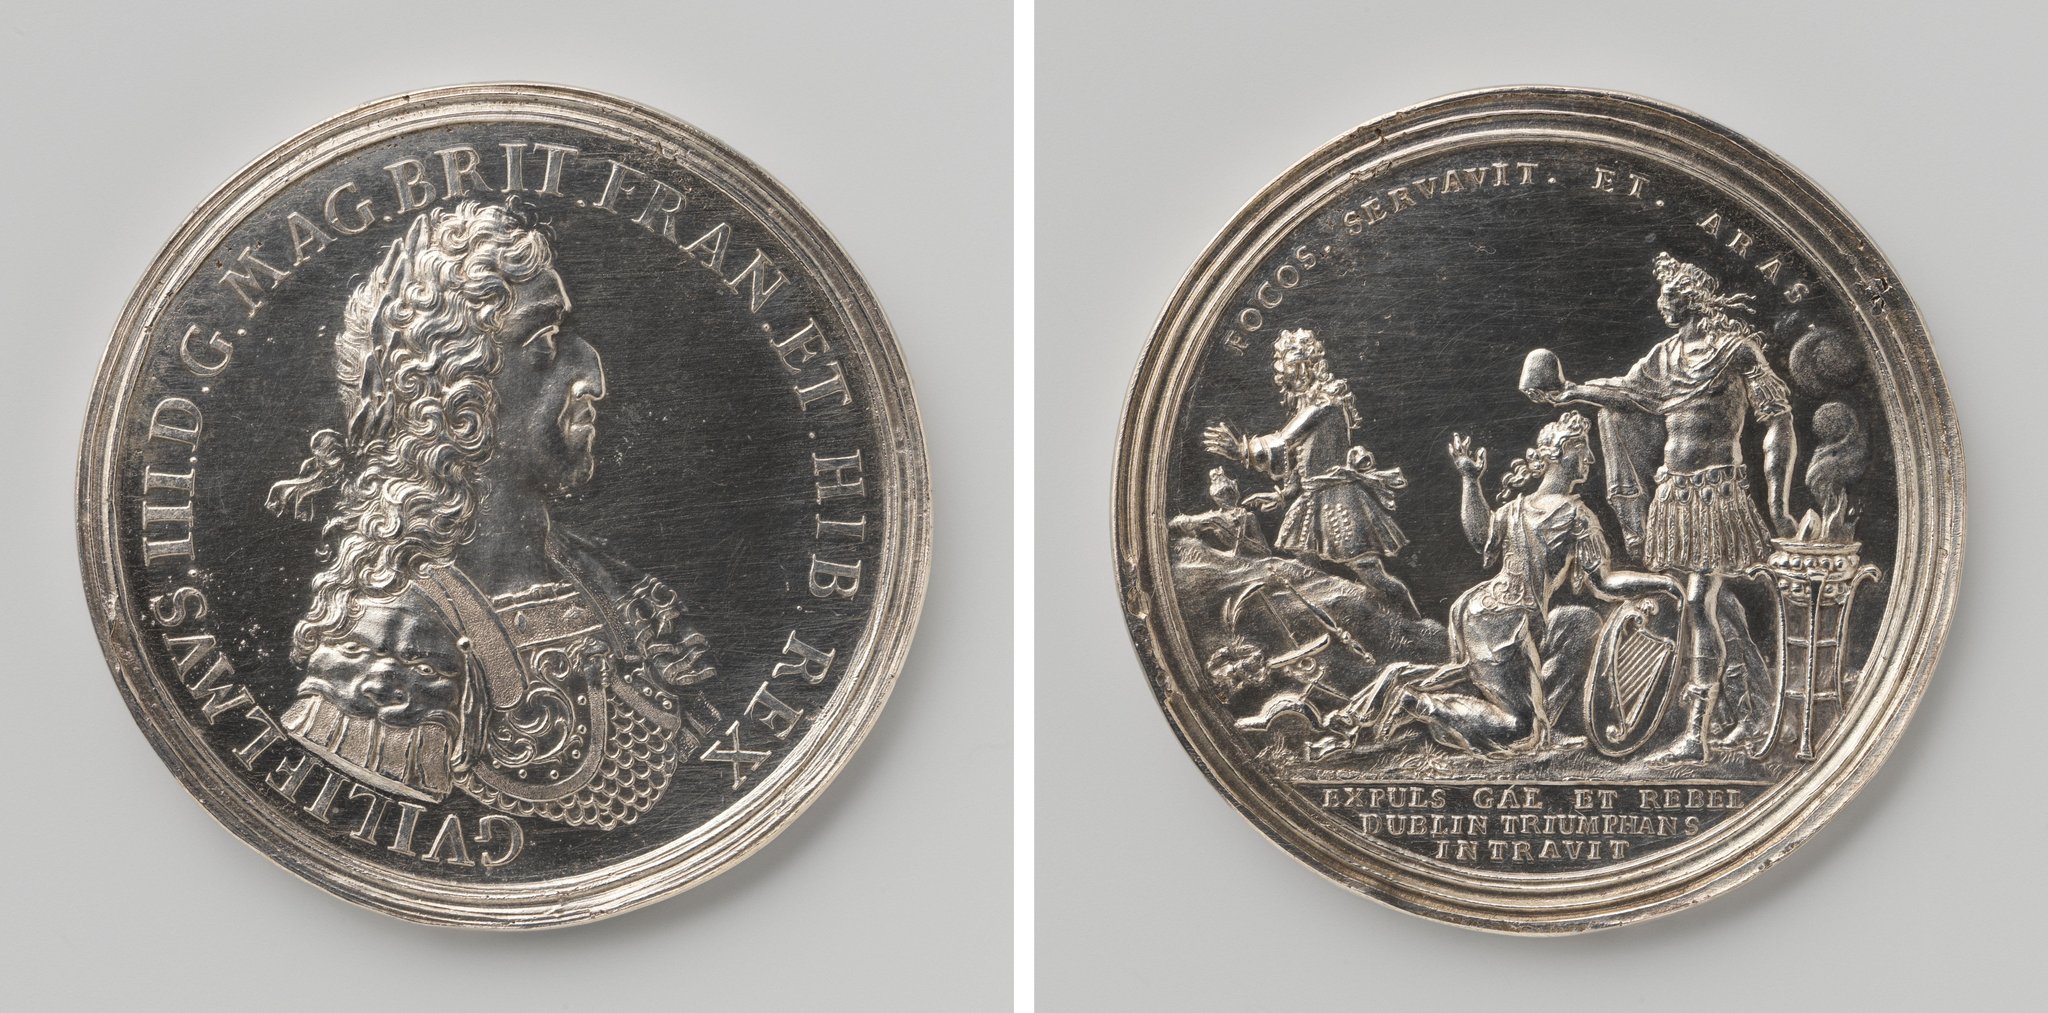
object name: history medal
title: Intocht van Willem III in Dublin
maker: jan luder (i)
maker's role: medailleur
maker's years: 1648-1719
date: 1690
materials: silver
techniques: striking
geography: netherlands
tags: the hague, william iii (prince of orange and king of england, scotland, and ireland)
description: Zilveren penning. Voorzijde: borststuk man met lauwerkrans binnen omschrift. Keerzijde: Willem in Romeinse kledij met hand rustend op brandend altaar zet Hibernia vrijheidshoed op, terwijl Jacobus en Frans soldaat vluchten binnen omschrift; afsnede: opschrift.